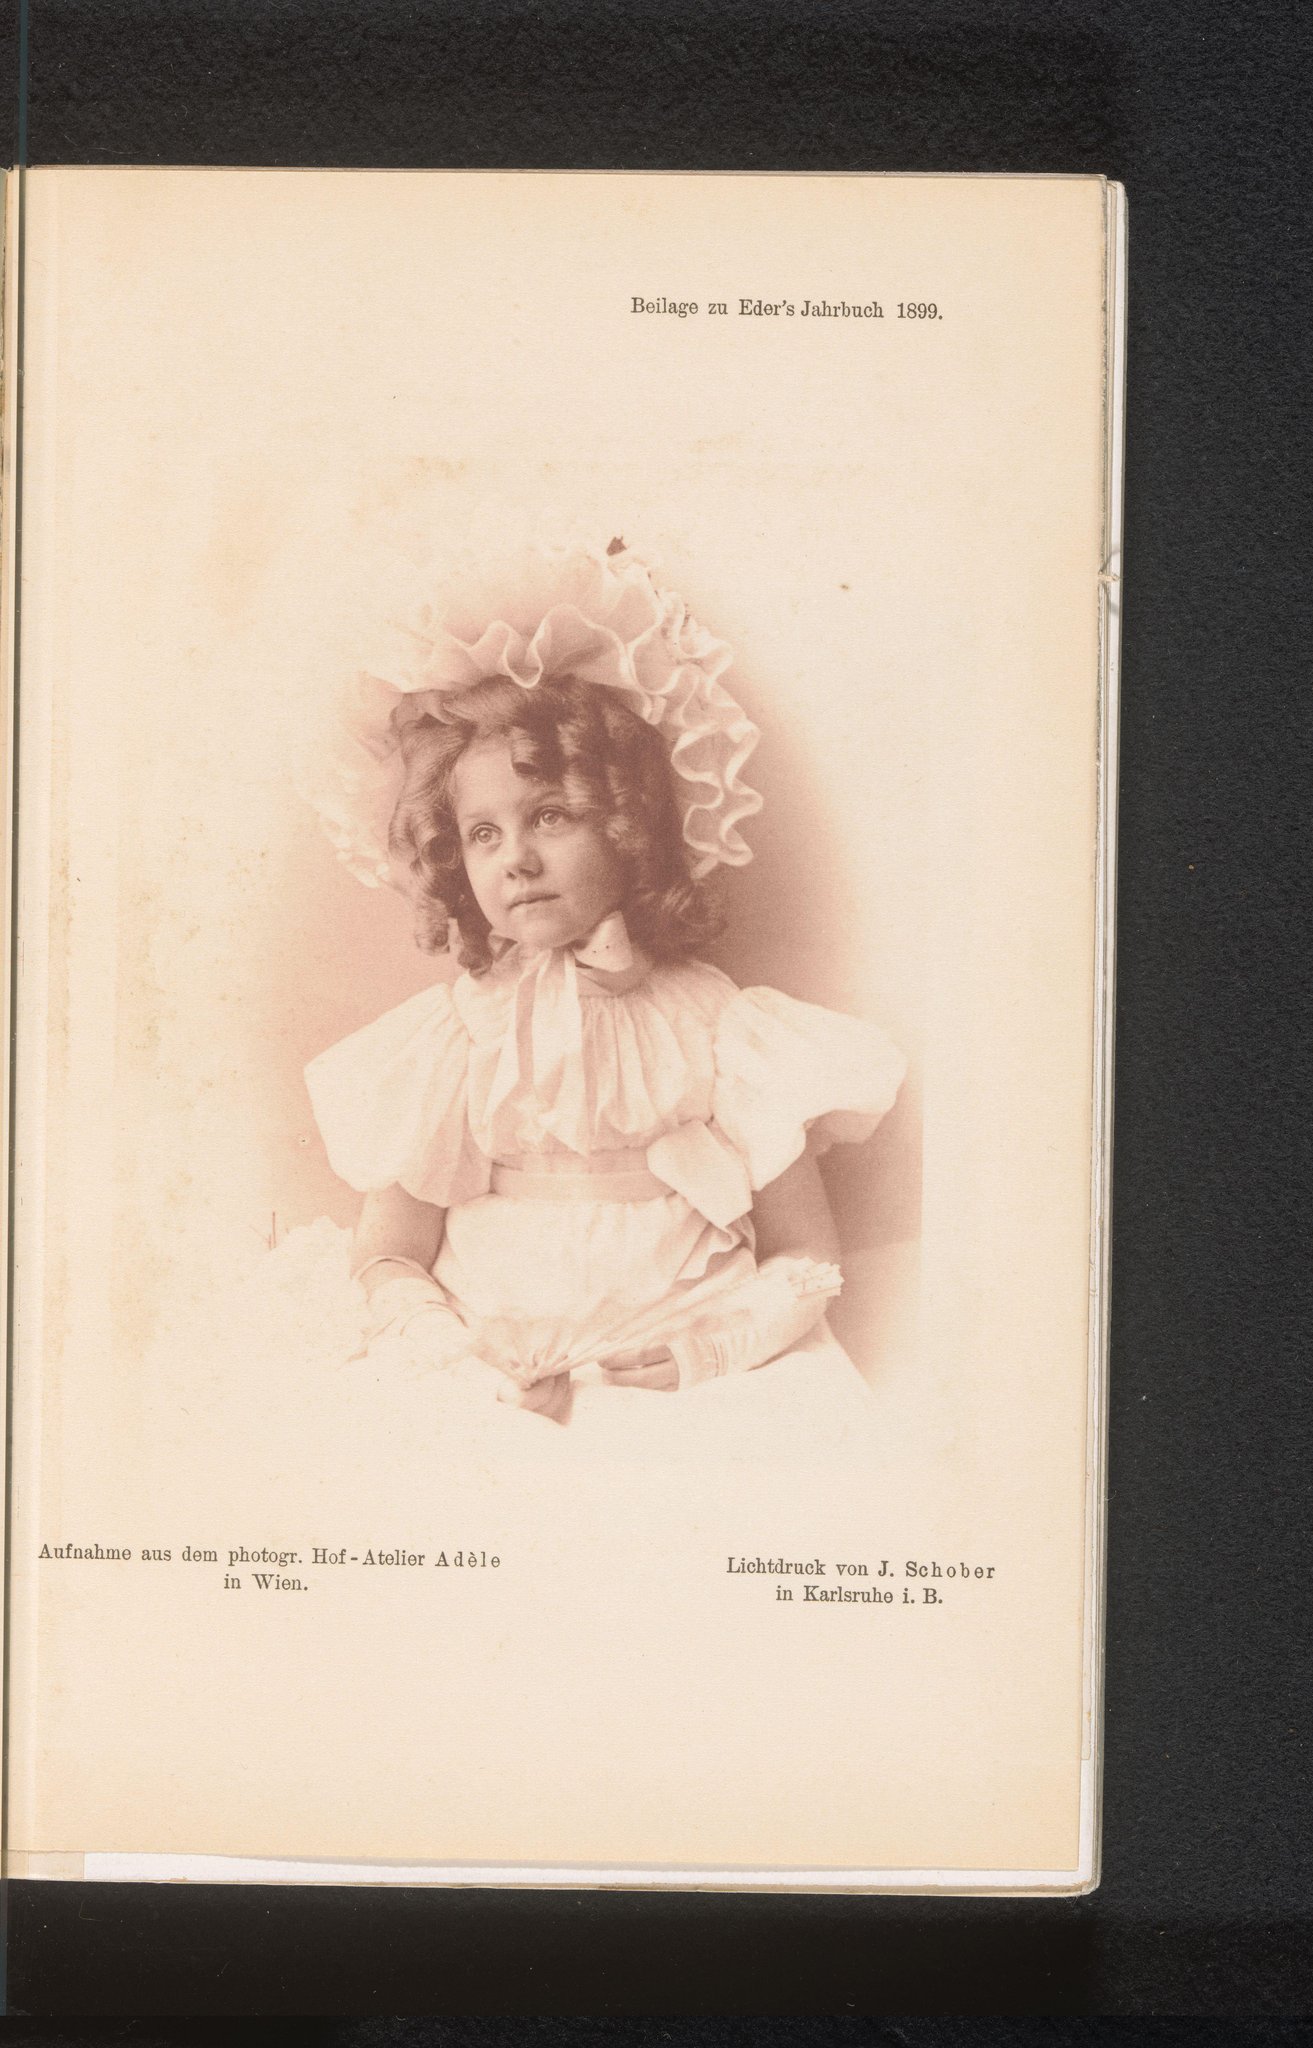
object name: photomechanical print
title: Portret van een onbekend meisje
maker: j. schober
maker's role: publisher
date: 1894-1899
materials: paper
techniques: photograph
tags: historical persons, girl (child between toddler and youth)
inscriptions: inscription: ‘Beilage zu Eder's Jahrbuch 1899.’